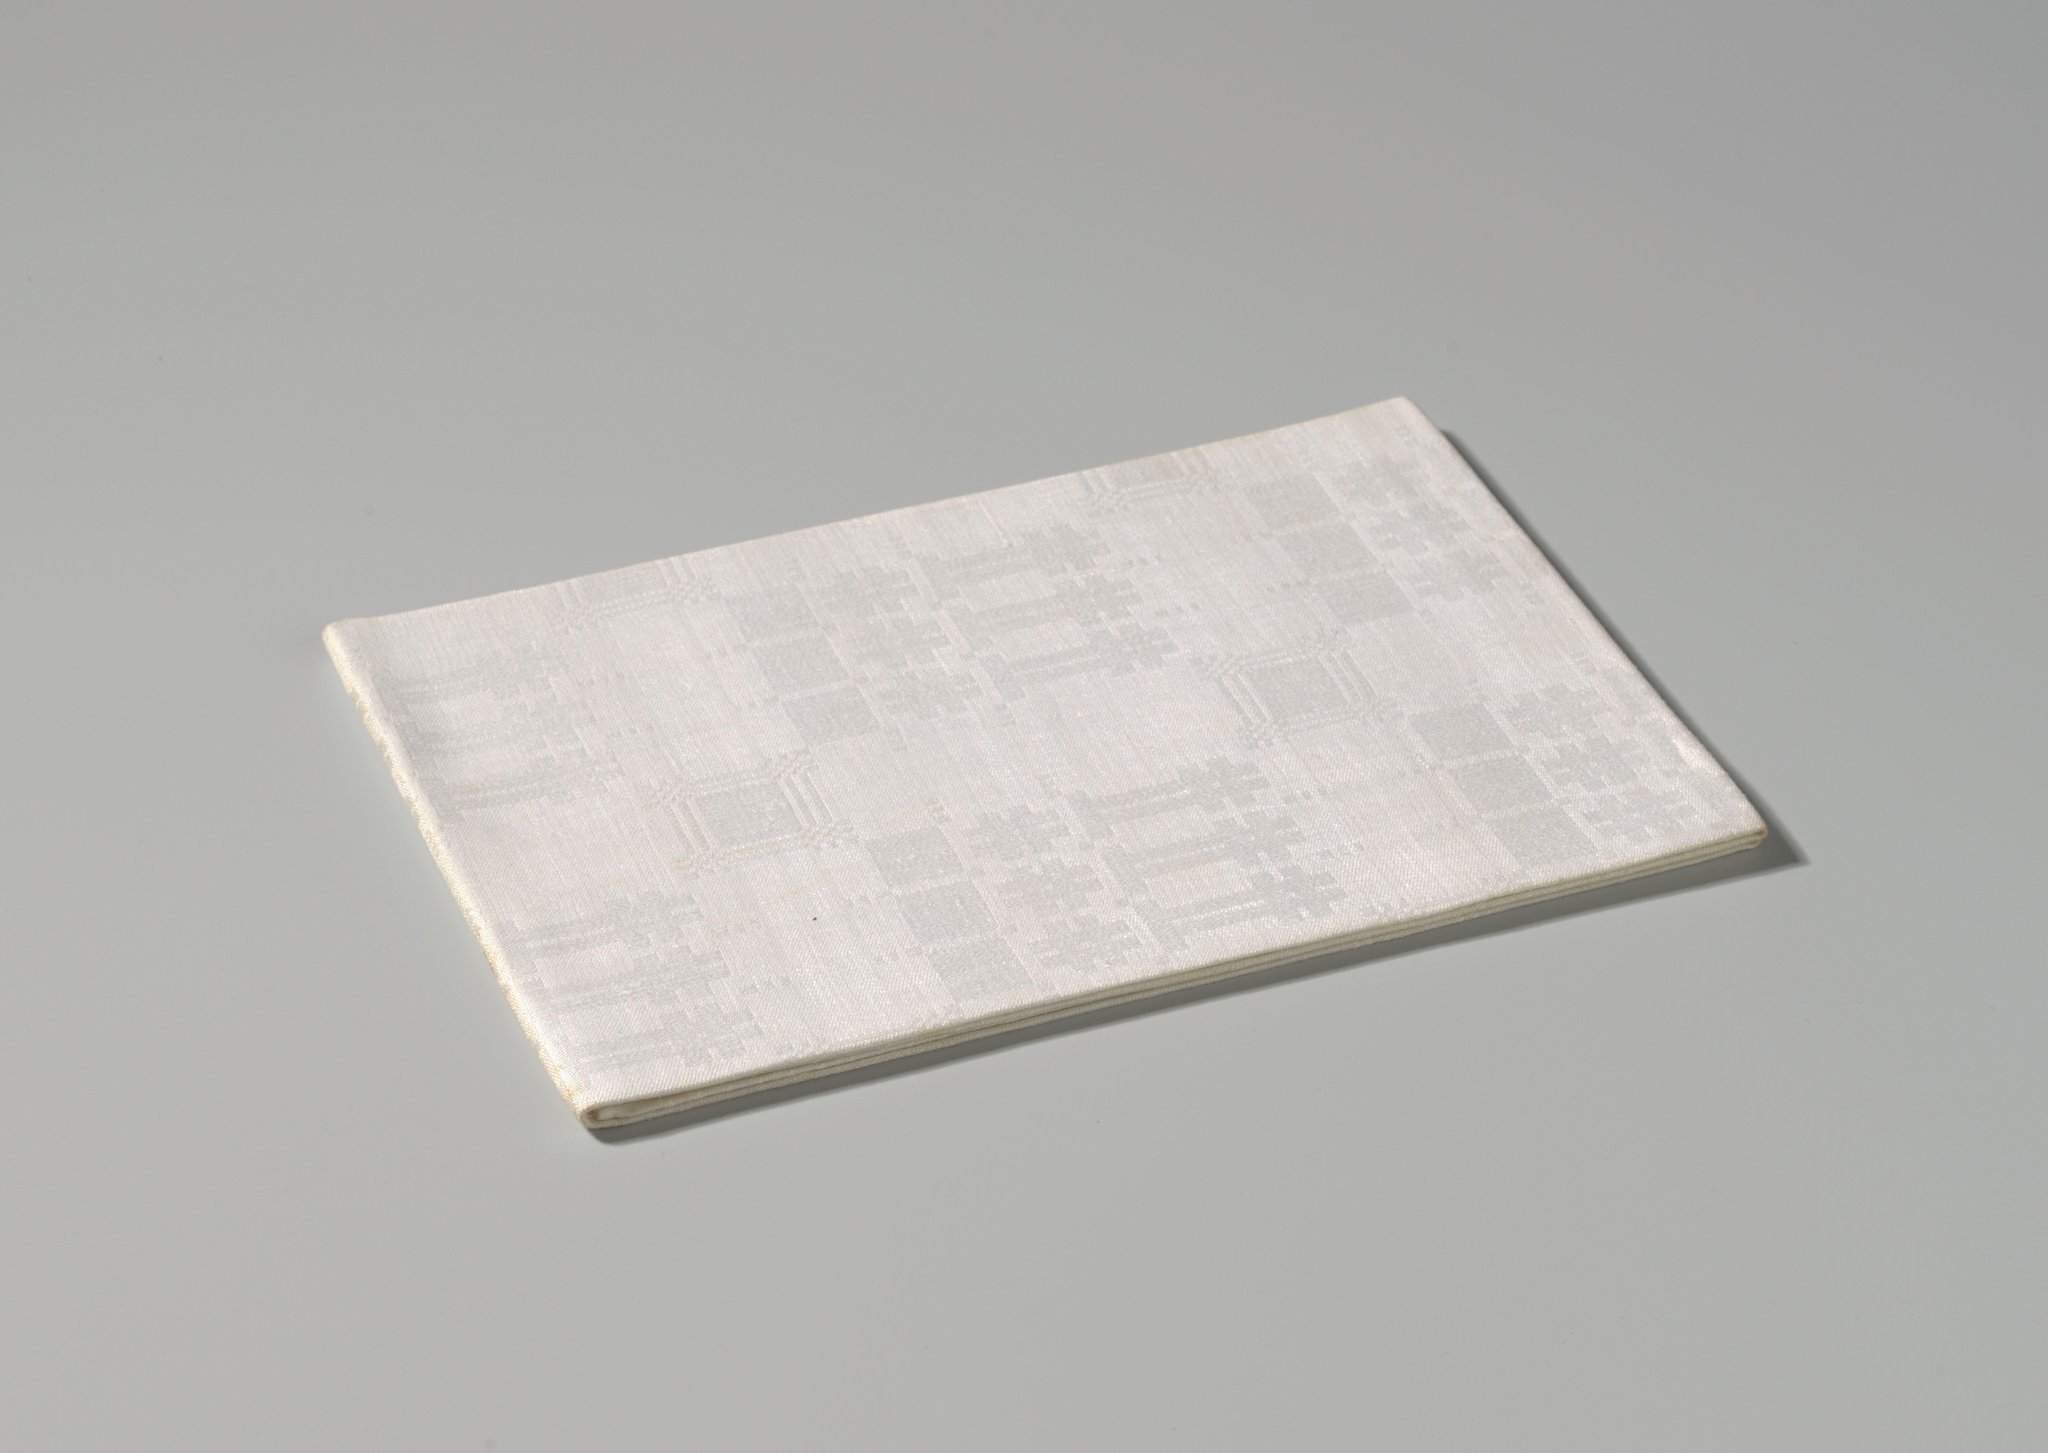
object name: napkin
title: Servet van linnen met pellenpatroon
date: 1725-1769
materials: linen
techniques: peeled fabric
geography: northern netherlands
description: wit linnen servet met pellen patroon, merk kroon ARVG 31